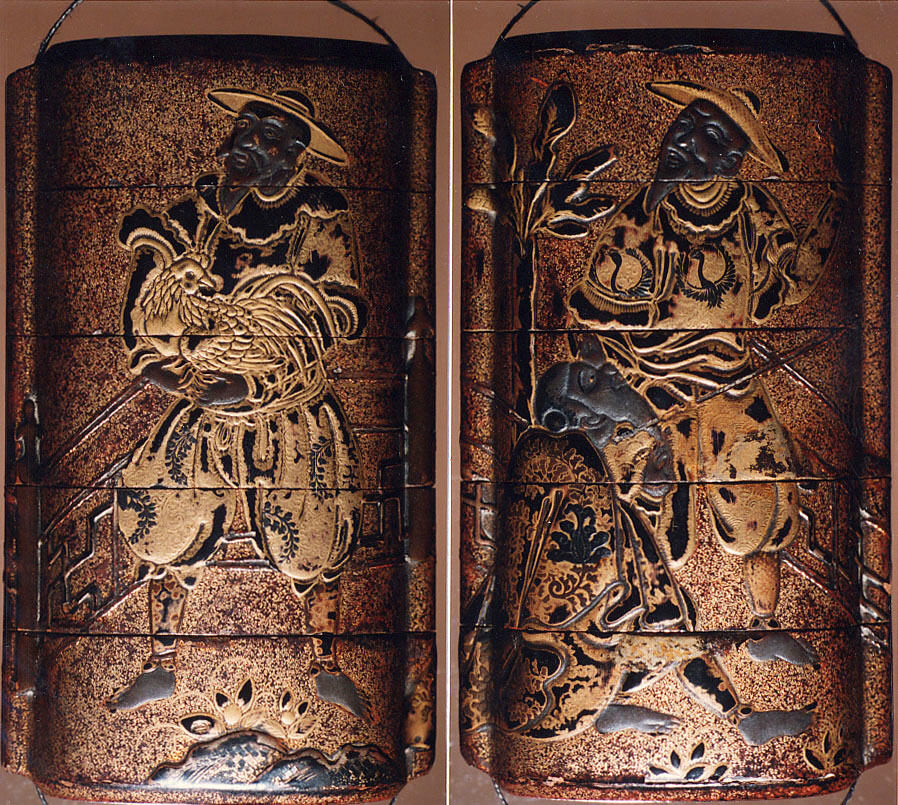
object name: inrō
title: Case (Inrō) with Design of Foreigners, One holding a Cock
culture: japanese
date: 1601-1800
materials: gold, lacquer, silver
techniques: fundame, hiramakie, roiro, maki-e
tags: men,roosters